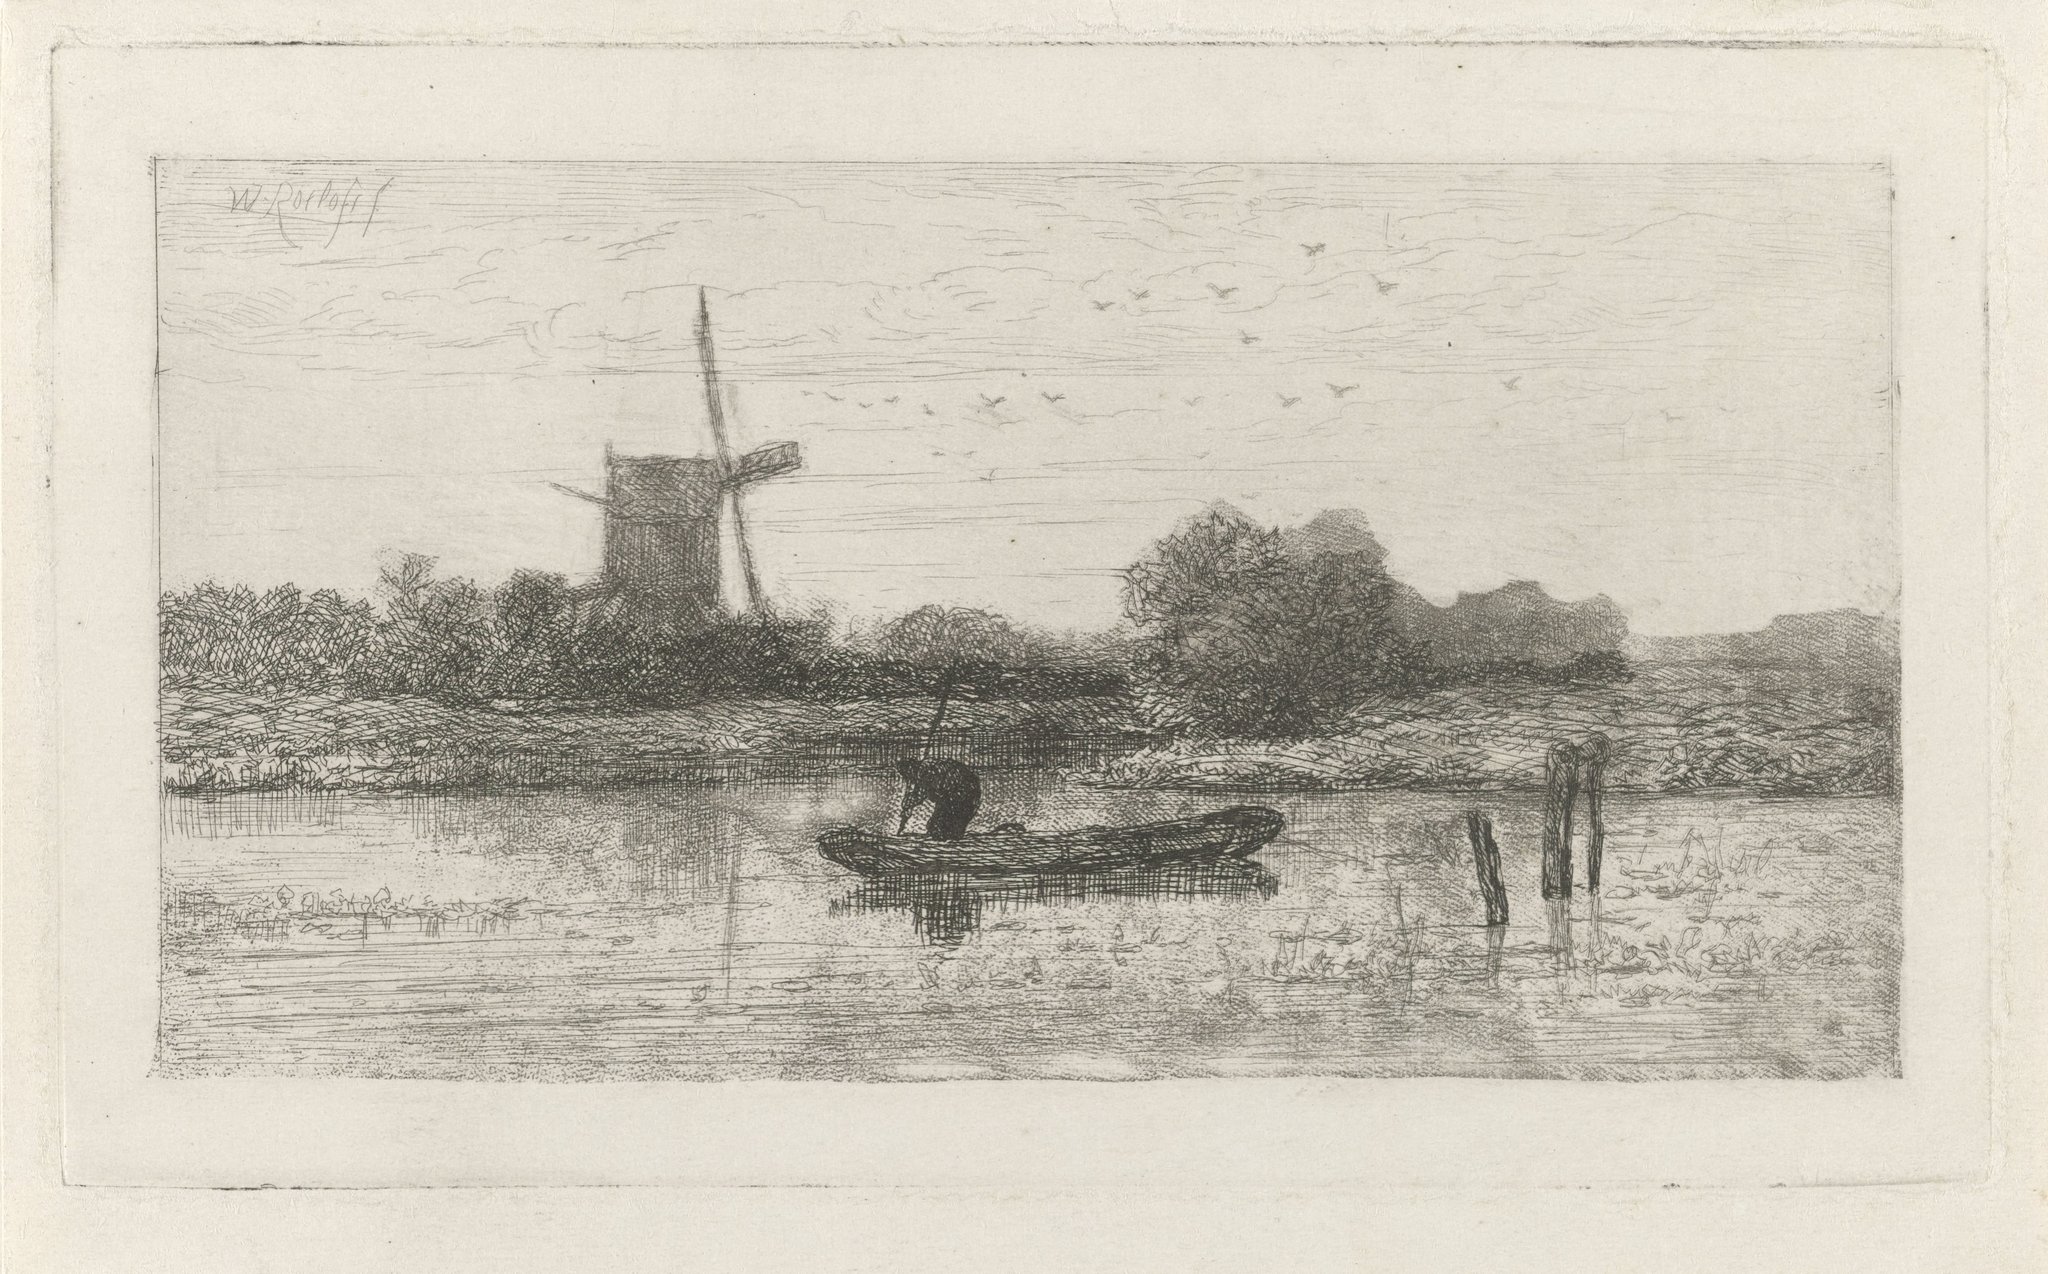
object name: print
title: Riviergezicht met visser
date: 1832-1886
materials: paper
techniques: etching, rocker stamped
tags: river, windmill, fisherman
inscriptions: collector's mark: Lugt 2228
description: Gezicht op een rivier met een visser in een boot. Op de achtergrond een molen.